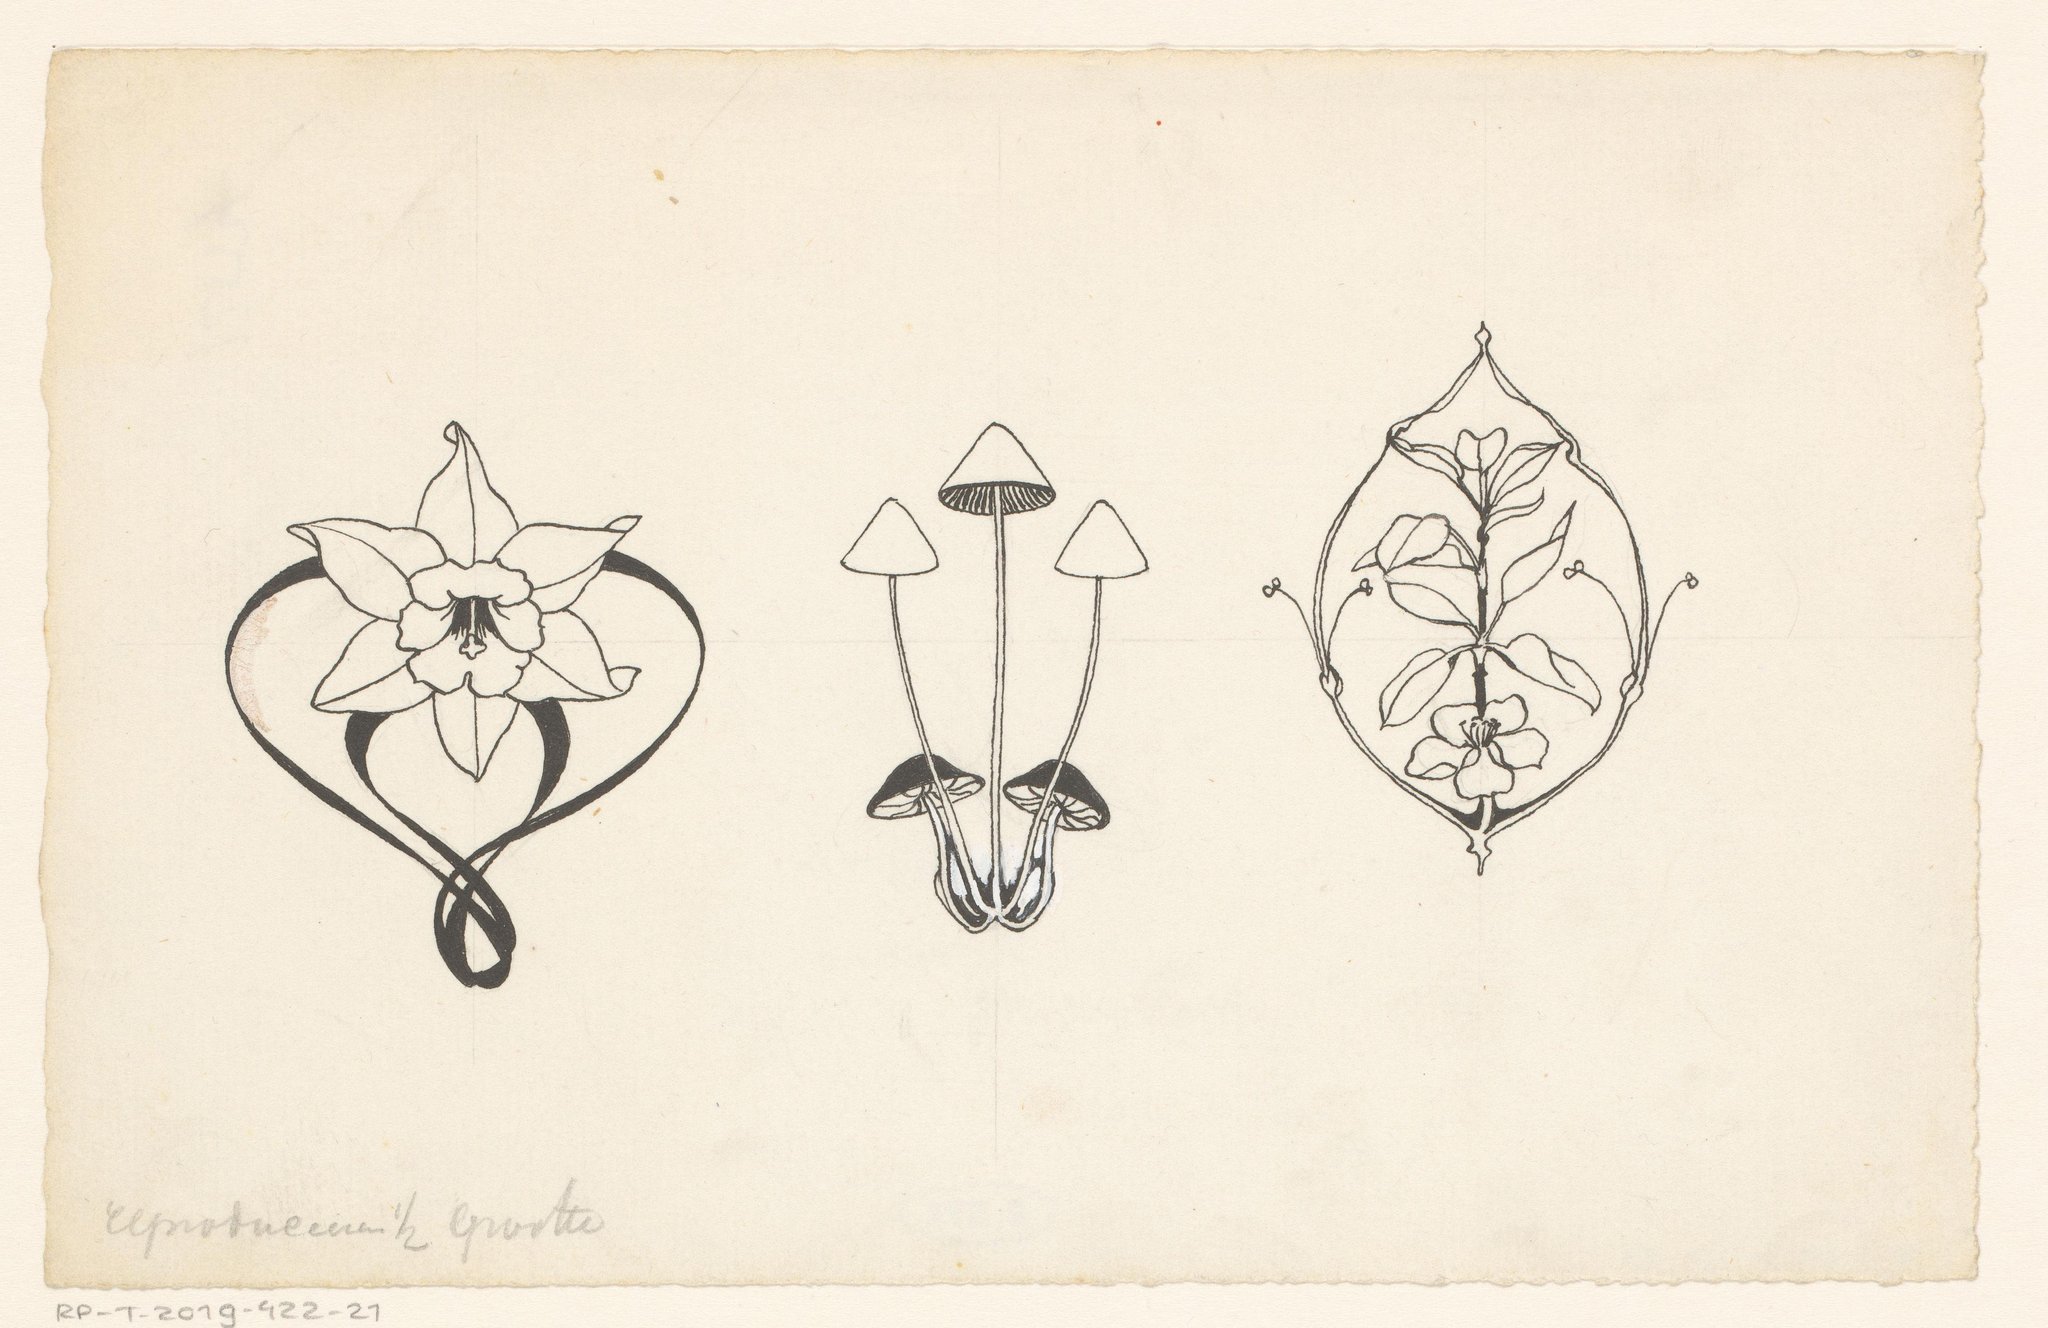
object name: drawing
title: Bloemen en paddenstoelen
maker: willem wenckebach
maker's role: designer, draughtsman, painter, print maker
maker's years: 1860-1937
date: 1870-1937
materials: paint, ink, paper, pencil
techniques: brush, pen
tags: flowers, mushrooms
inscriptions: :, collector's mark: Lugt 2228